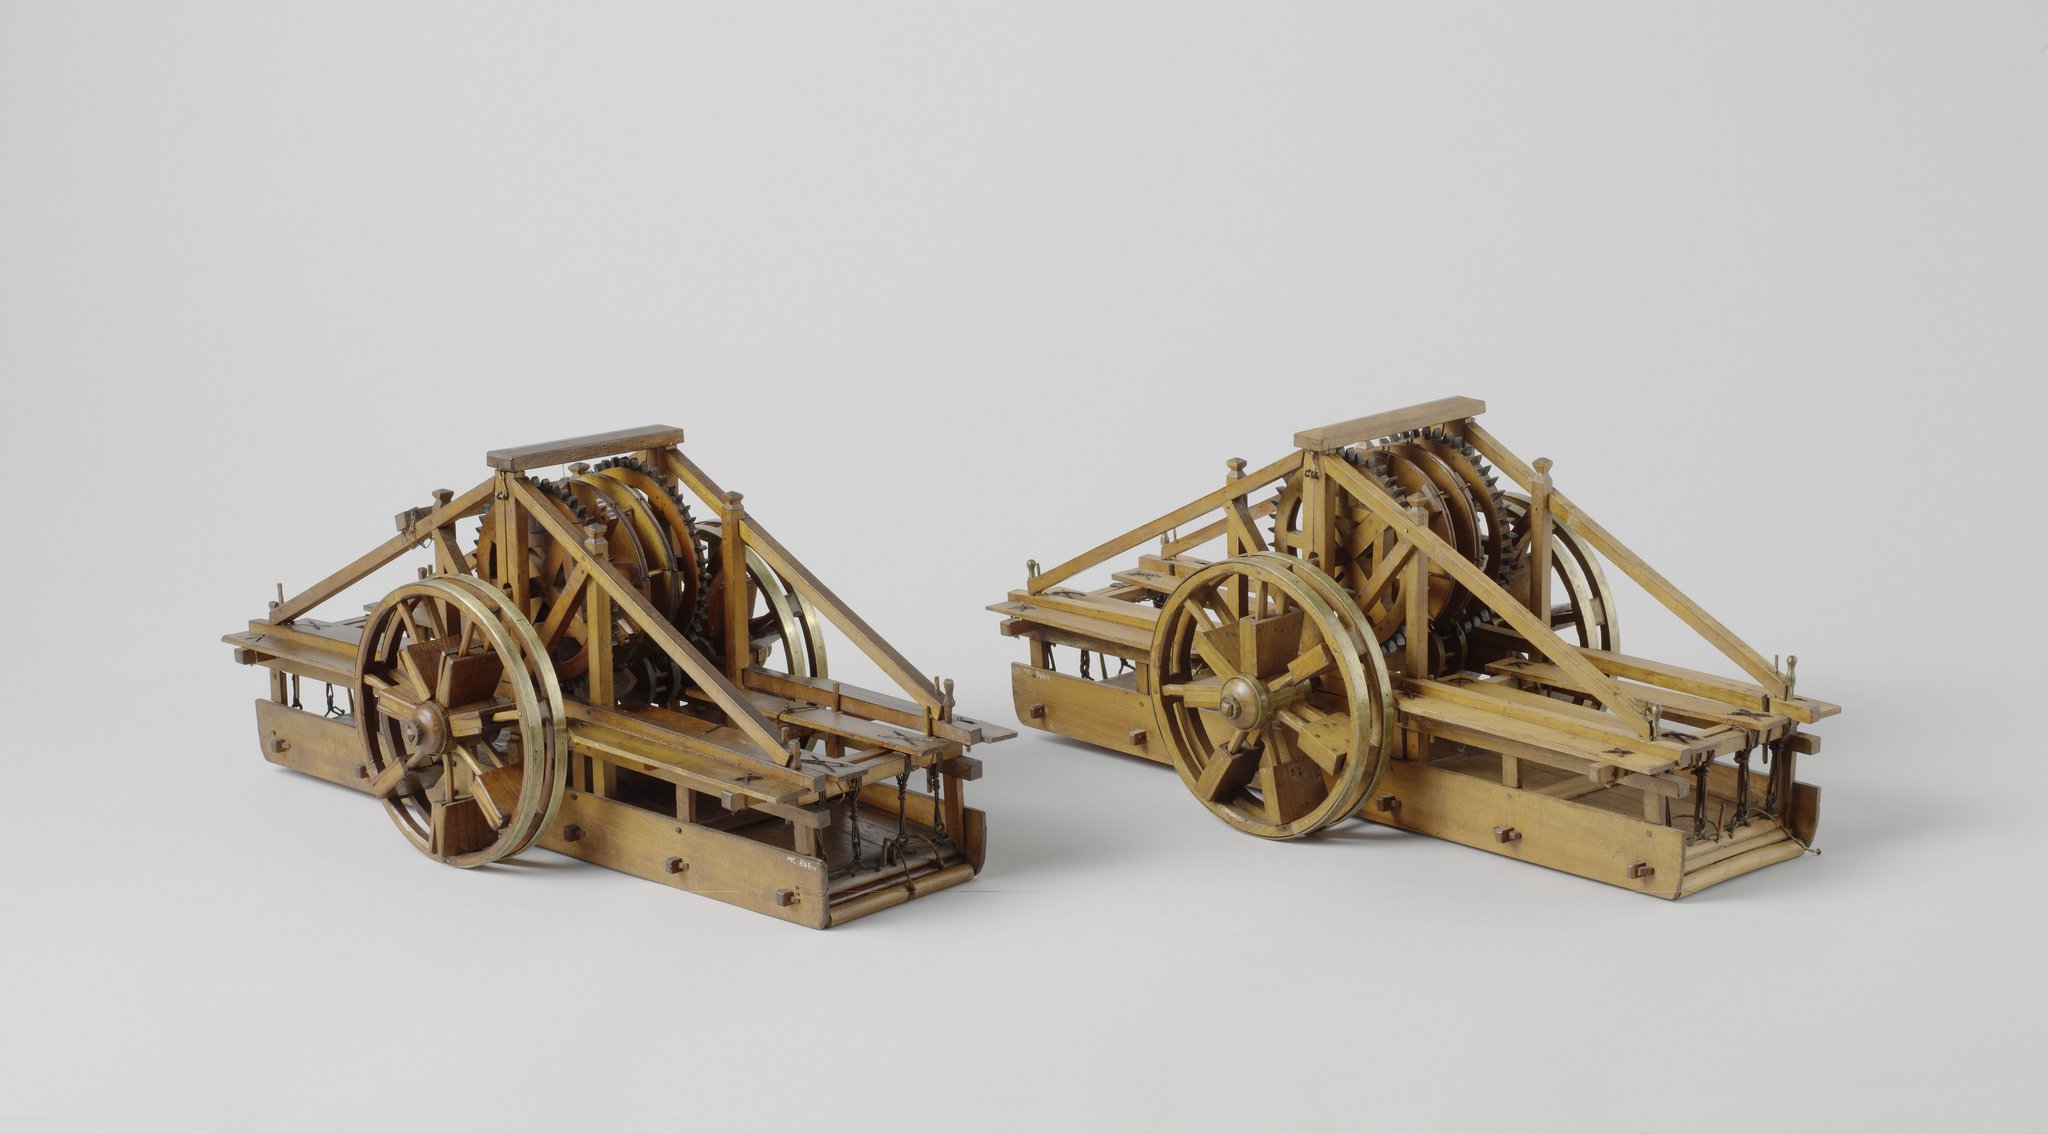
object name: demonstration model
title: Model of a Life-Saving Cart for Shipwrecks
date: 1832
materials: brass, fiber, wood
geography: rotterdam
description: Reddingstoestel voor reddingsoperaties bij schipbreuk op een strand. Het is een tweewielige wagen met de wielen in het midden; de wielen hebben zeven dubbele spaken, waaromheen schoepen zijn gemonteerd, die naar boven en beneden kunnen bewegen: deze inrichting dient waarschijnlijk om met behulp van het gewicht der telkens vallende schoepen de wenteling der wielen te bevorderen. De wielen worden aangedreven door een raderwerk in een houten raamwerk in het midden, dat een overbrenging heeft van 8/45 in tegengestelde richting.